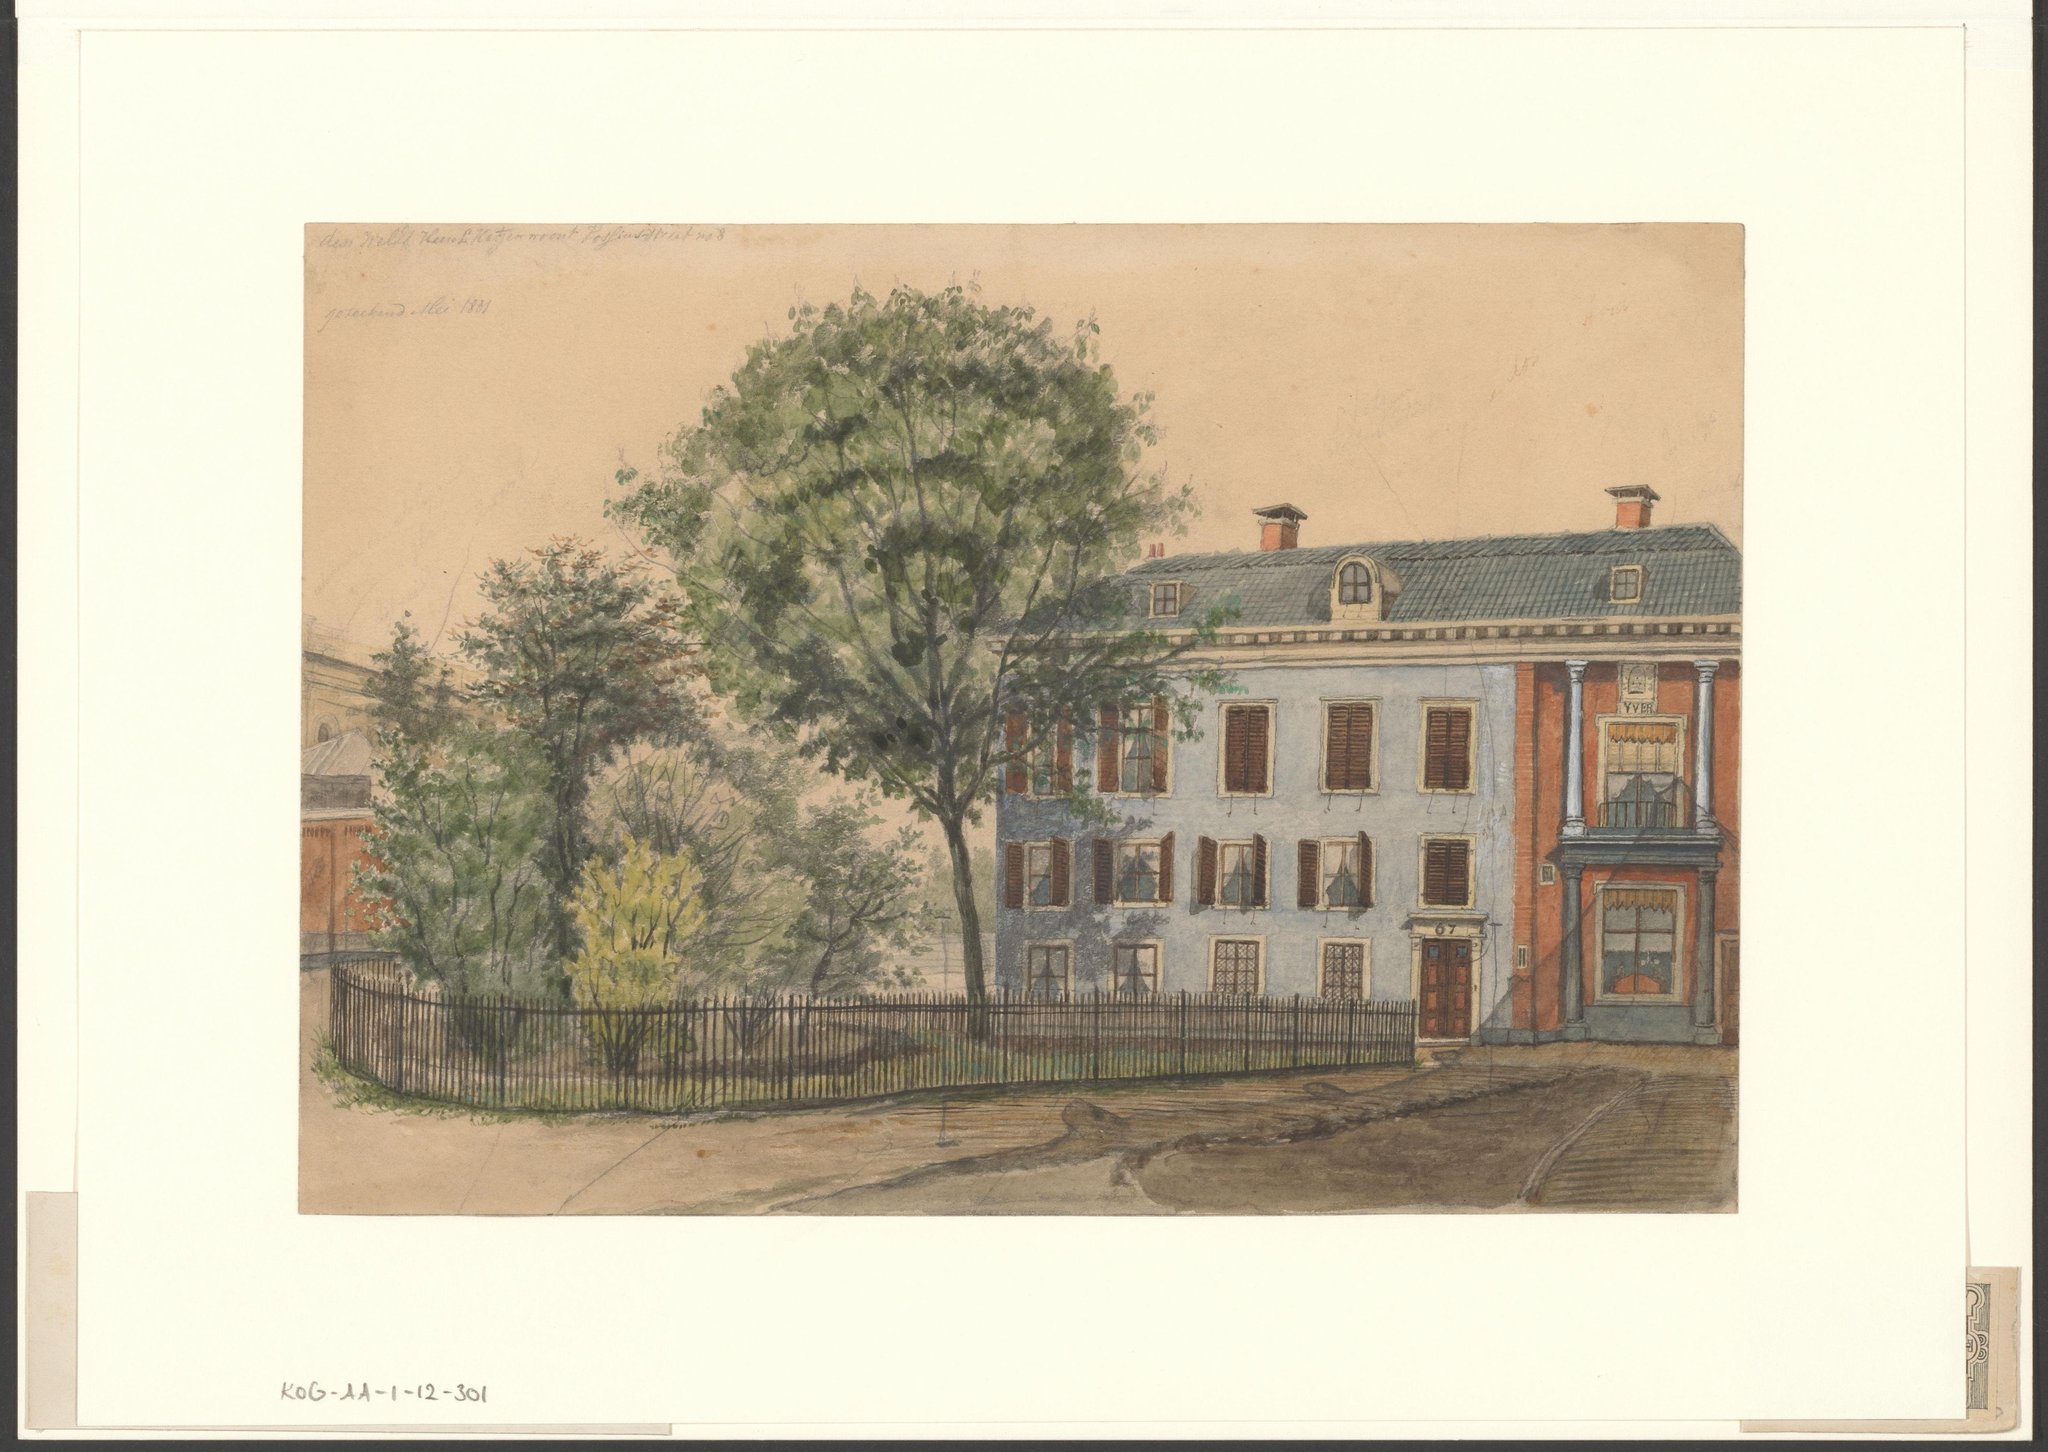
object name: drawing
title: Gezicht op het huis van de heer Ketjen aan de Trapjesschans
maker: johan george lodewijk rieke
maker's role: draughtsman, print maker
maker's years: 1817-1898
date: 1805-1881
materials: chalk, paint, gouache, ink, paper, pencil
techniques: brush, pen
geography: amsterdam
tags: city-view in general; 'veduta', the usual house or row of houses, street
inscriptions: inscription: ‘586 Het Huis (...) 22. B. 30.’, collector's mark: ‘12’ Lugt 1641b, stamp: ‘Van het Koninklijk / Oudheidkundig Genootschap / te Amsterdam.’, collector's mark: ‘1711’ Lugt 1811, inscription: ‘den Wel[...] Heere L. Ketjen woont Pos[...]straat 108 / geteekend Mei 1881’, inscription: ‘Port. 12-301’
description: Onderwerpsrubriek binnen de Atlas Amsterdam: Sarphatistraat, Schans.